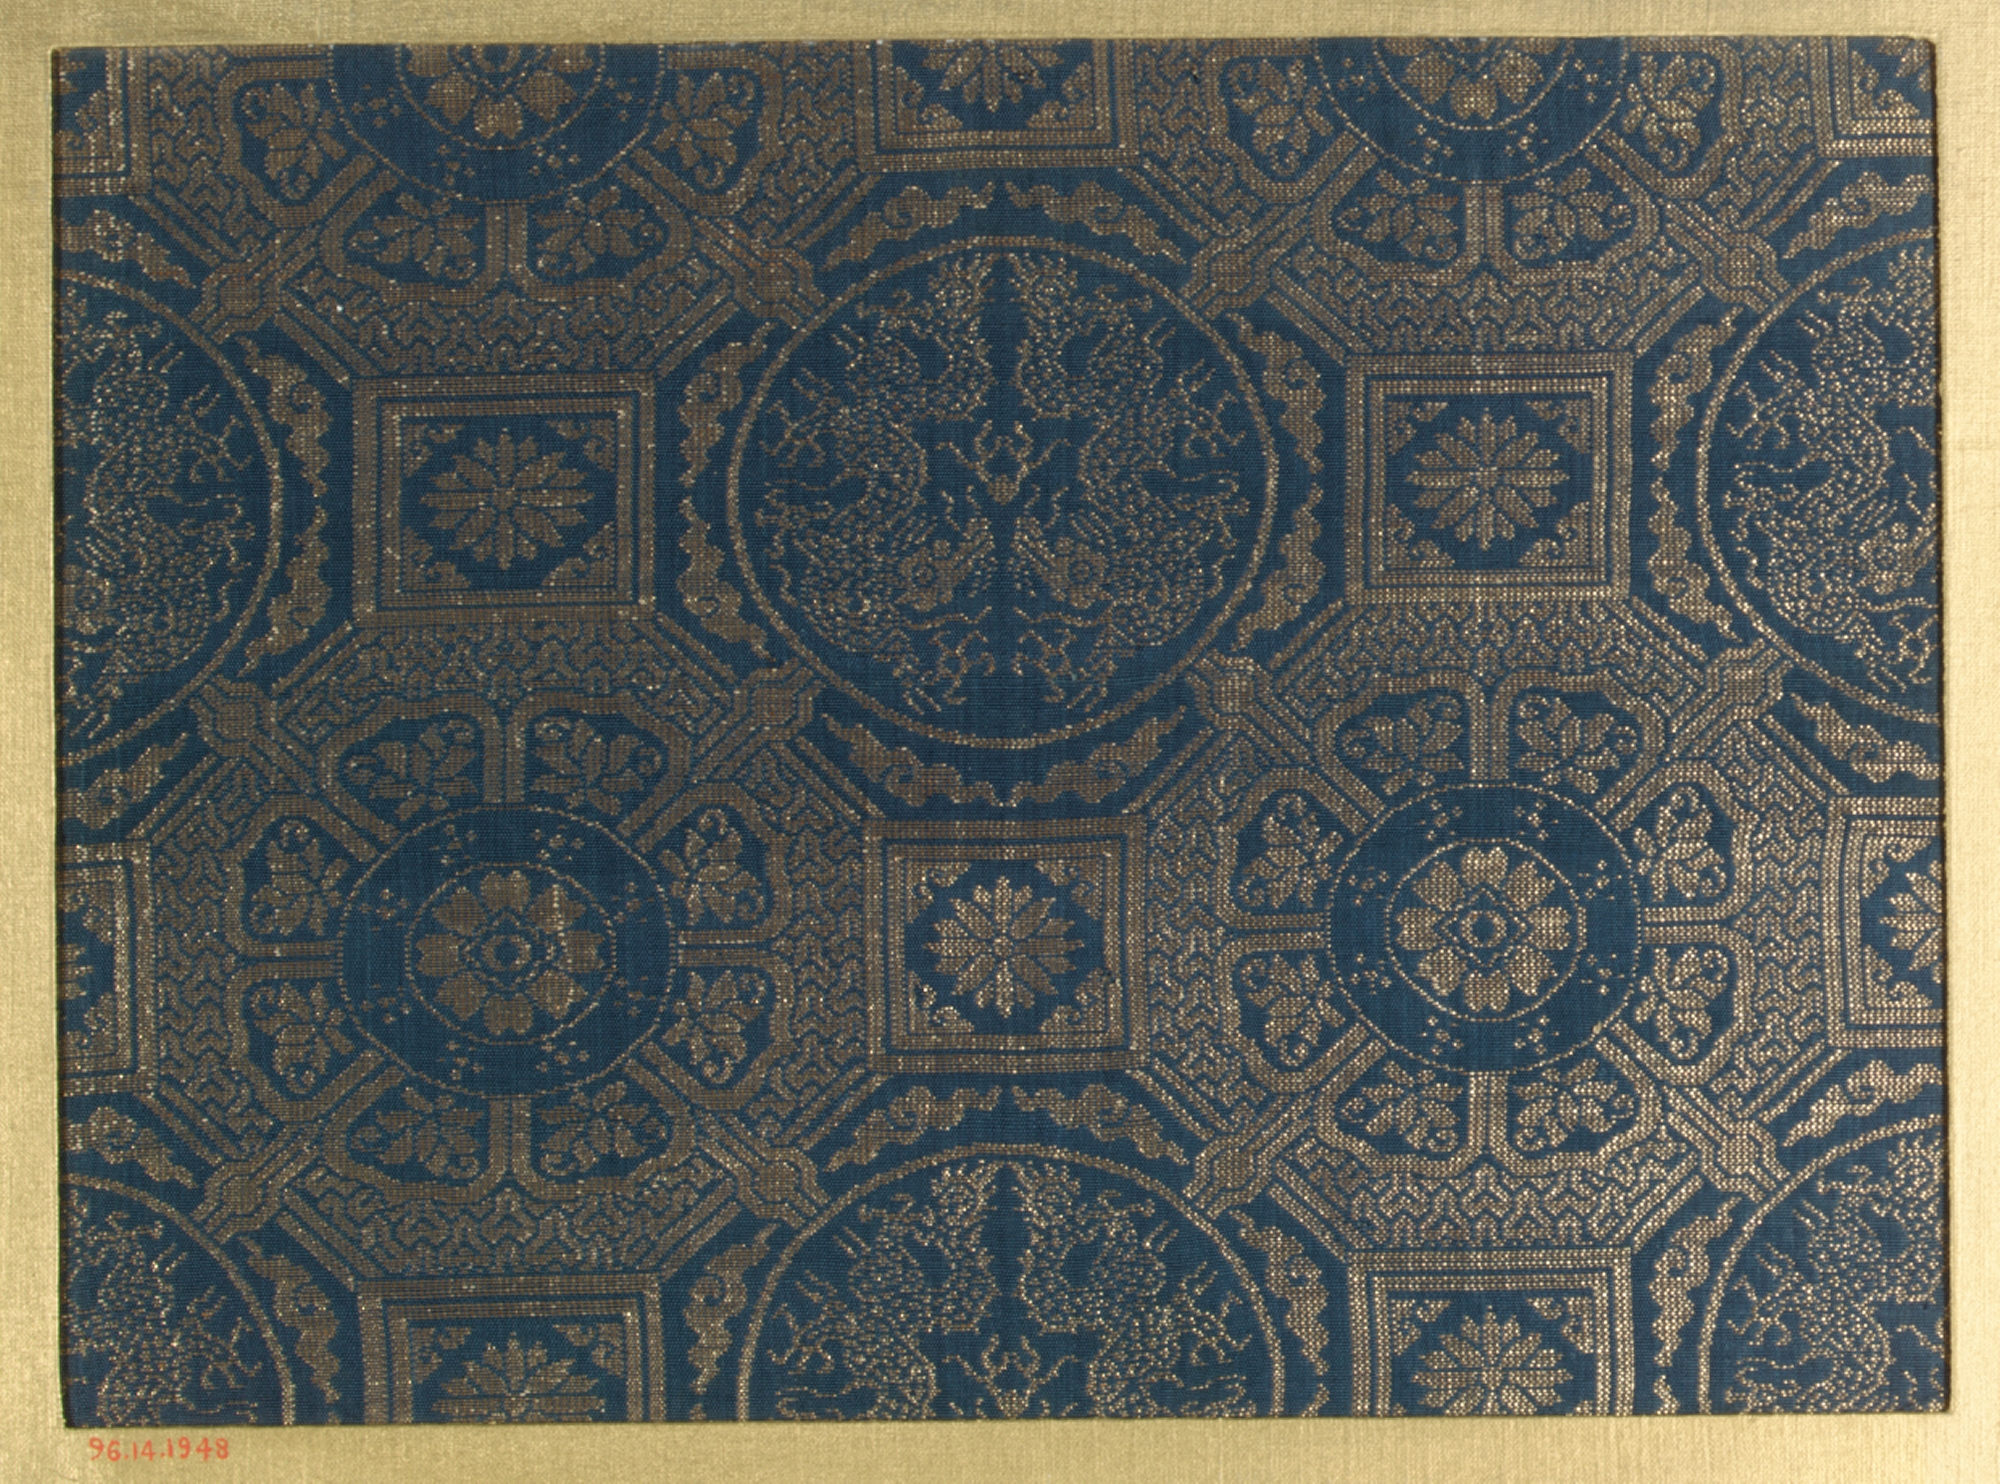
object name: piece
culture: japanese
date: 1701-1900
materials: silk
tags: flowers